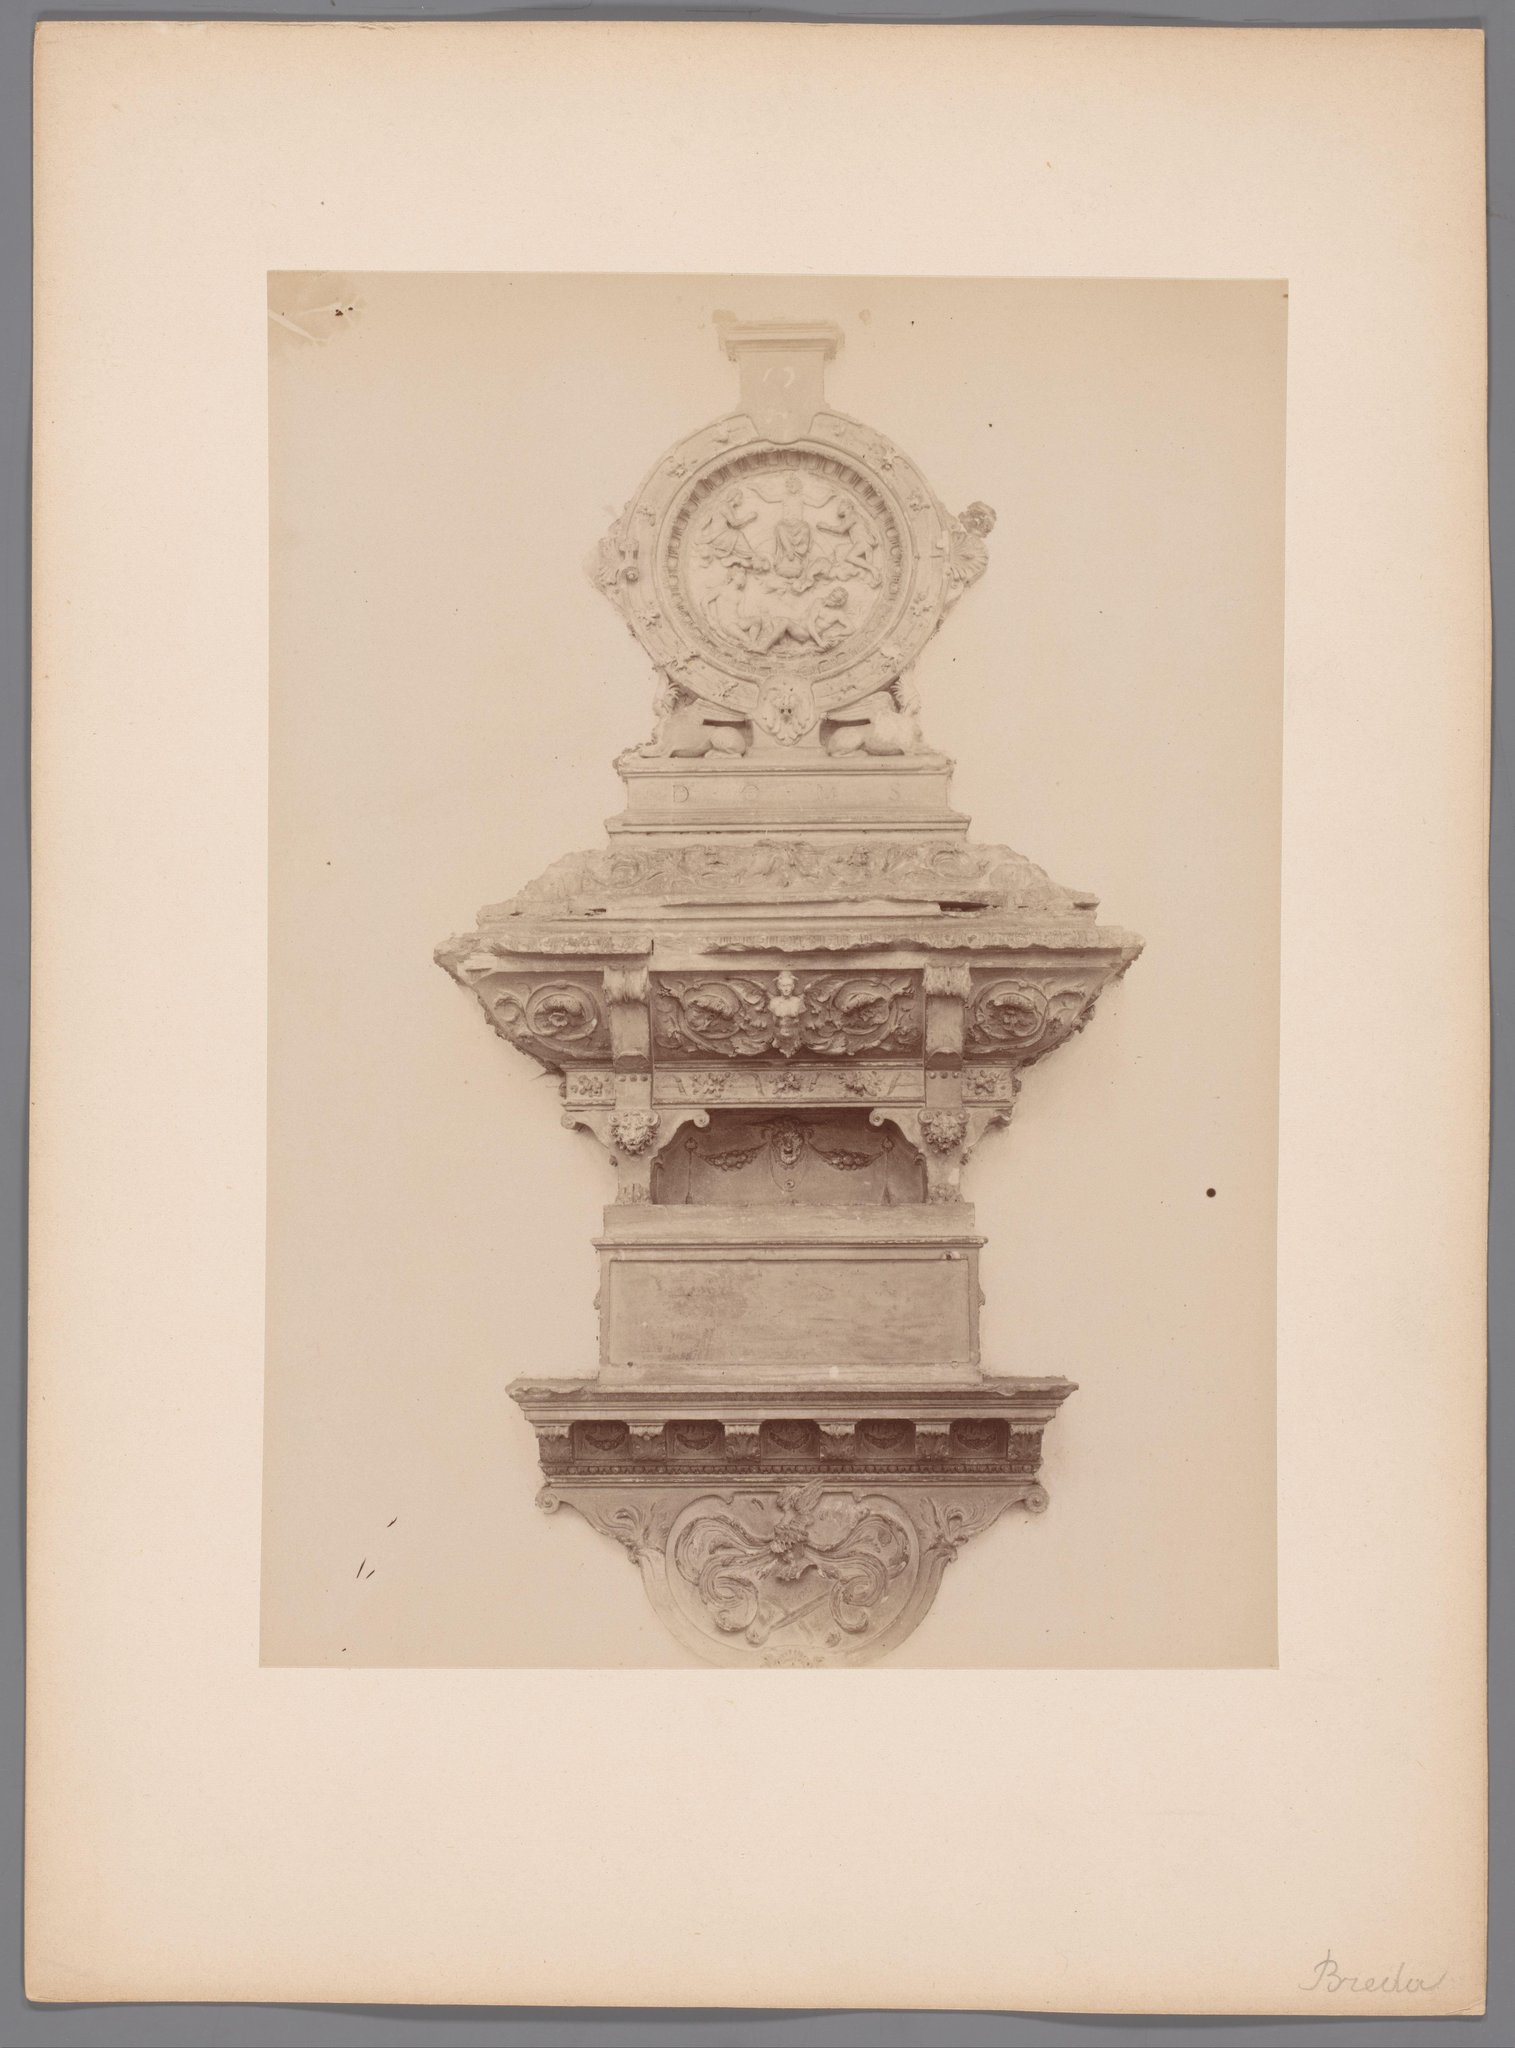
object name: photograph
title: Epitaaf de Biest in de Grote Kerk te Breda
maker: anoniem (monumentenzorg)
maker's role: fotograaf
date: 1890-1920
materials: cardboard, photographic support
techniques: albumen print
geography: grote kerk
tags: interior of church, epitaph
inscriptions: annotation: ‘Breda’, annotation: ‘Breda/ grafmonument in de Ned. Herv. Kerk’